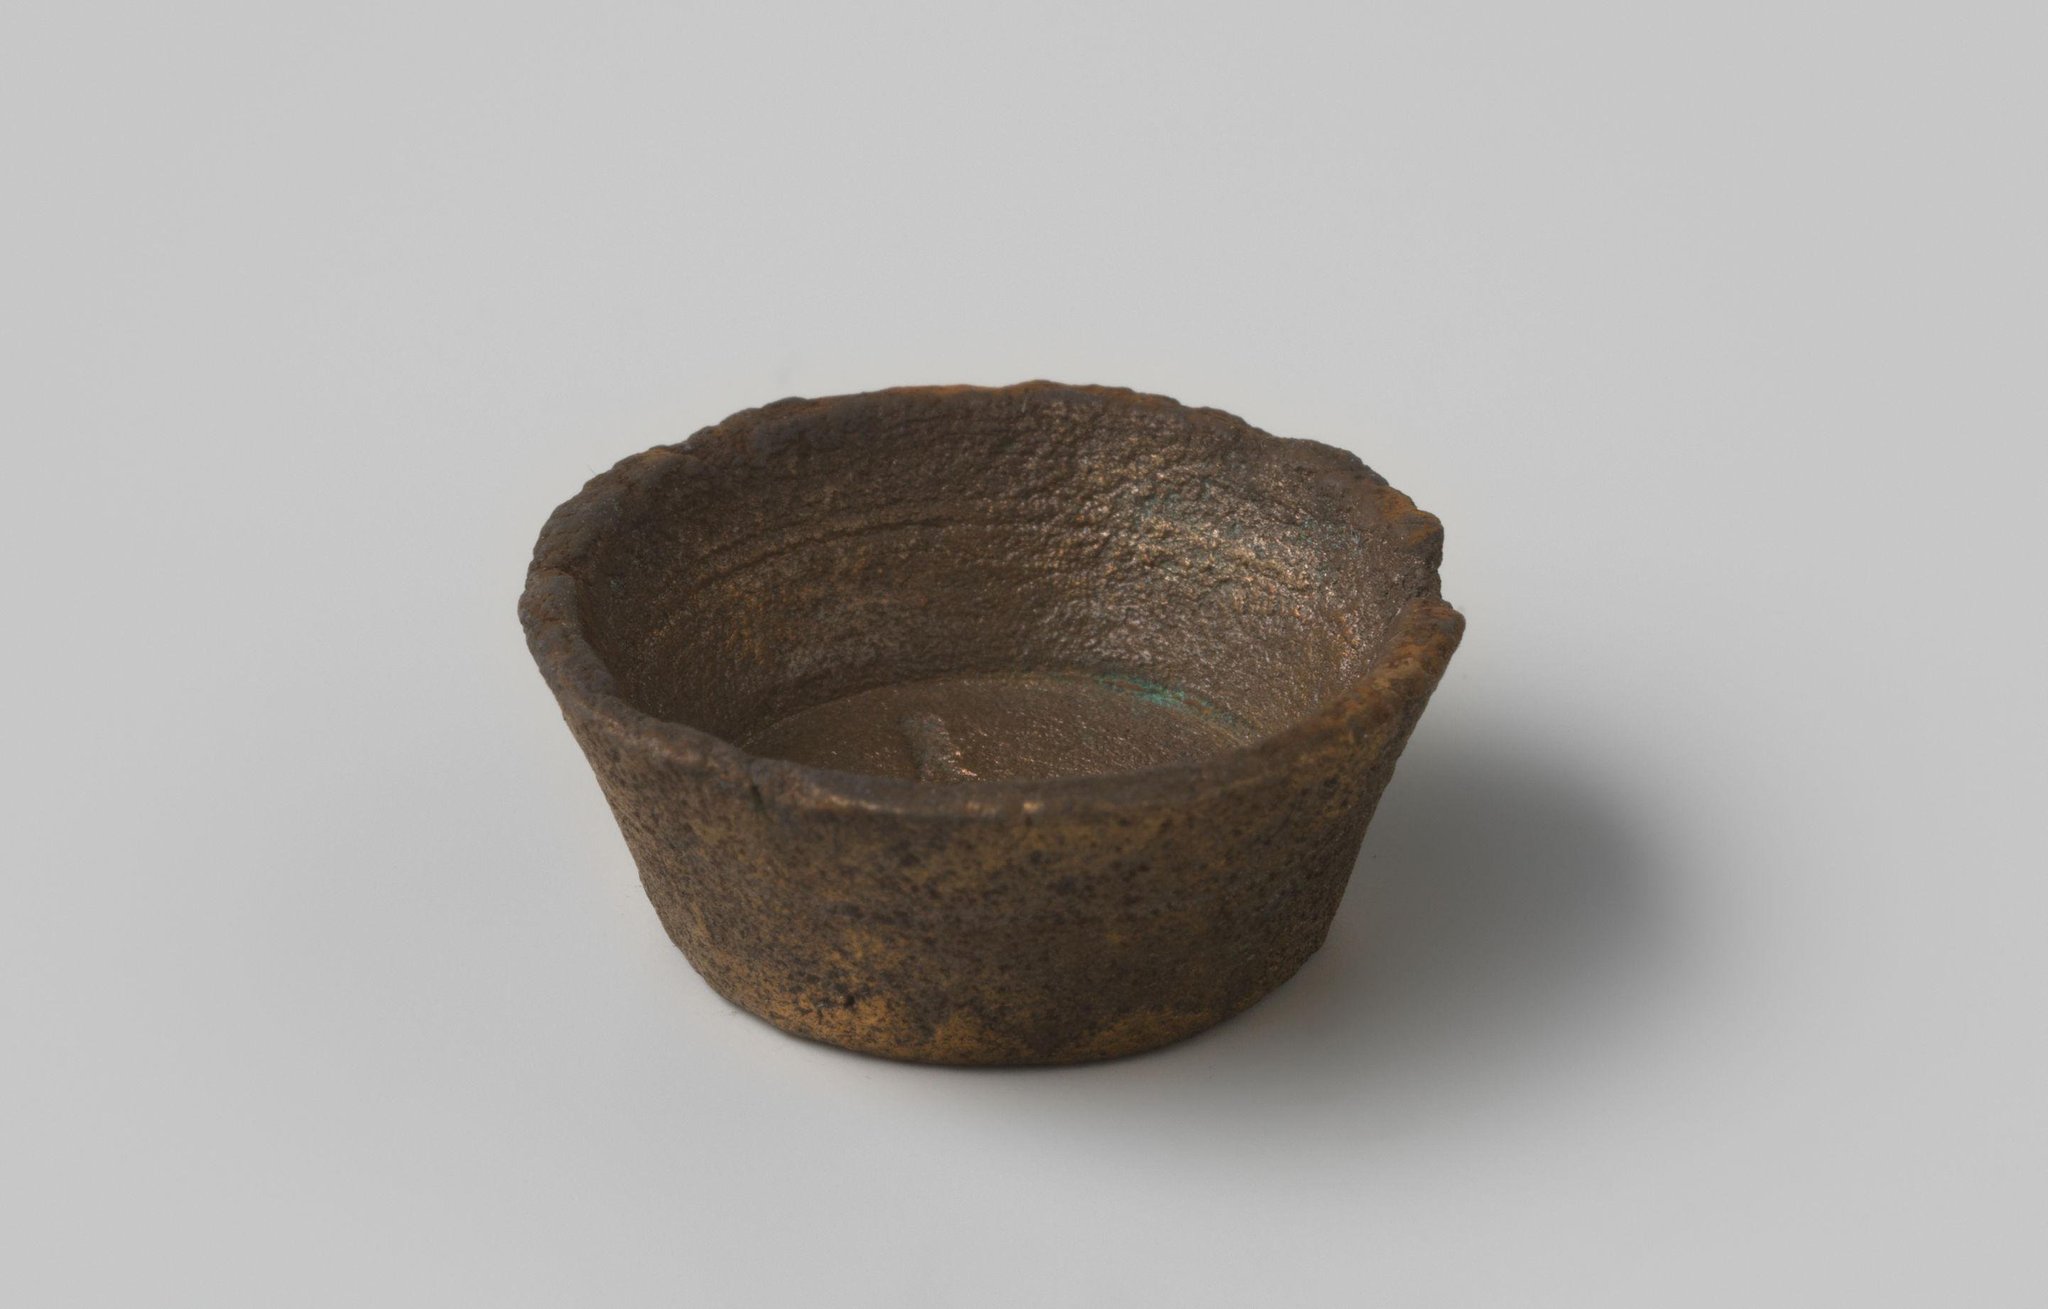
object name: sluitgewicht, pijlgewicht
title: Gewicht van sluitgewicht uit het wrak van de Oost-Indiëvaarder Hollandia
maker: Anonymous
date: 1700-1743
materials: copper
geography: netherlands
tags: verenigde oostindische compagnie, hollandia (schip), annet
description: Weight, cupweight, cup; id. NG 1980-27H2775, id. marks.